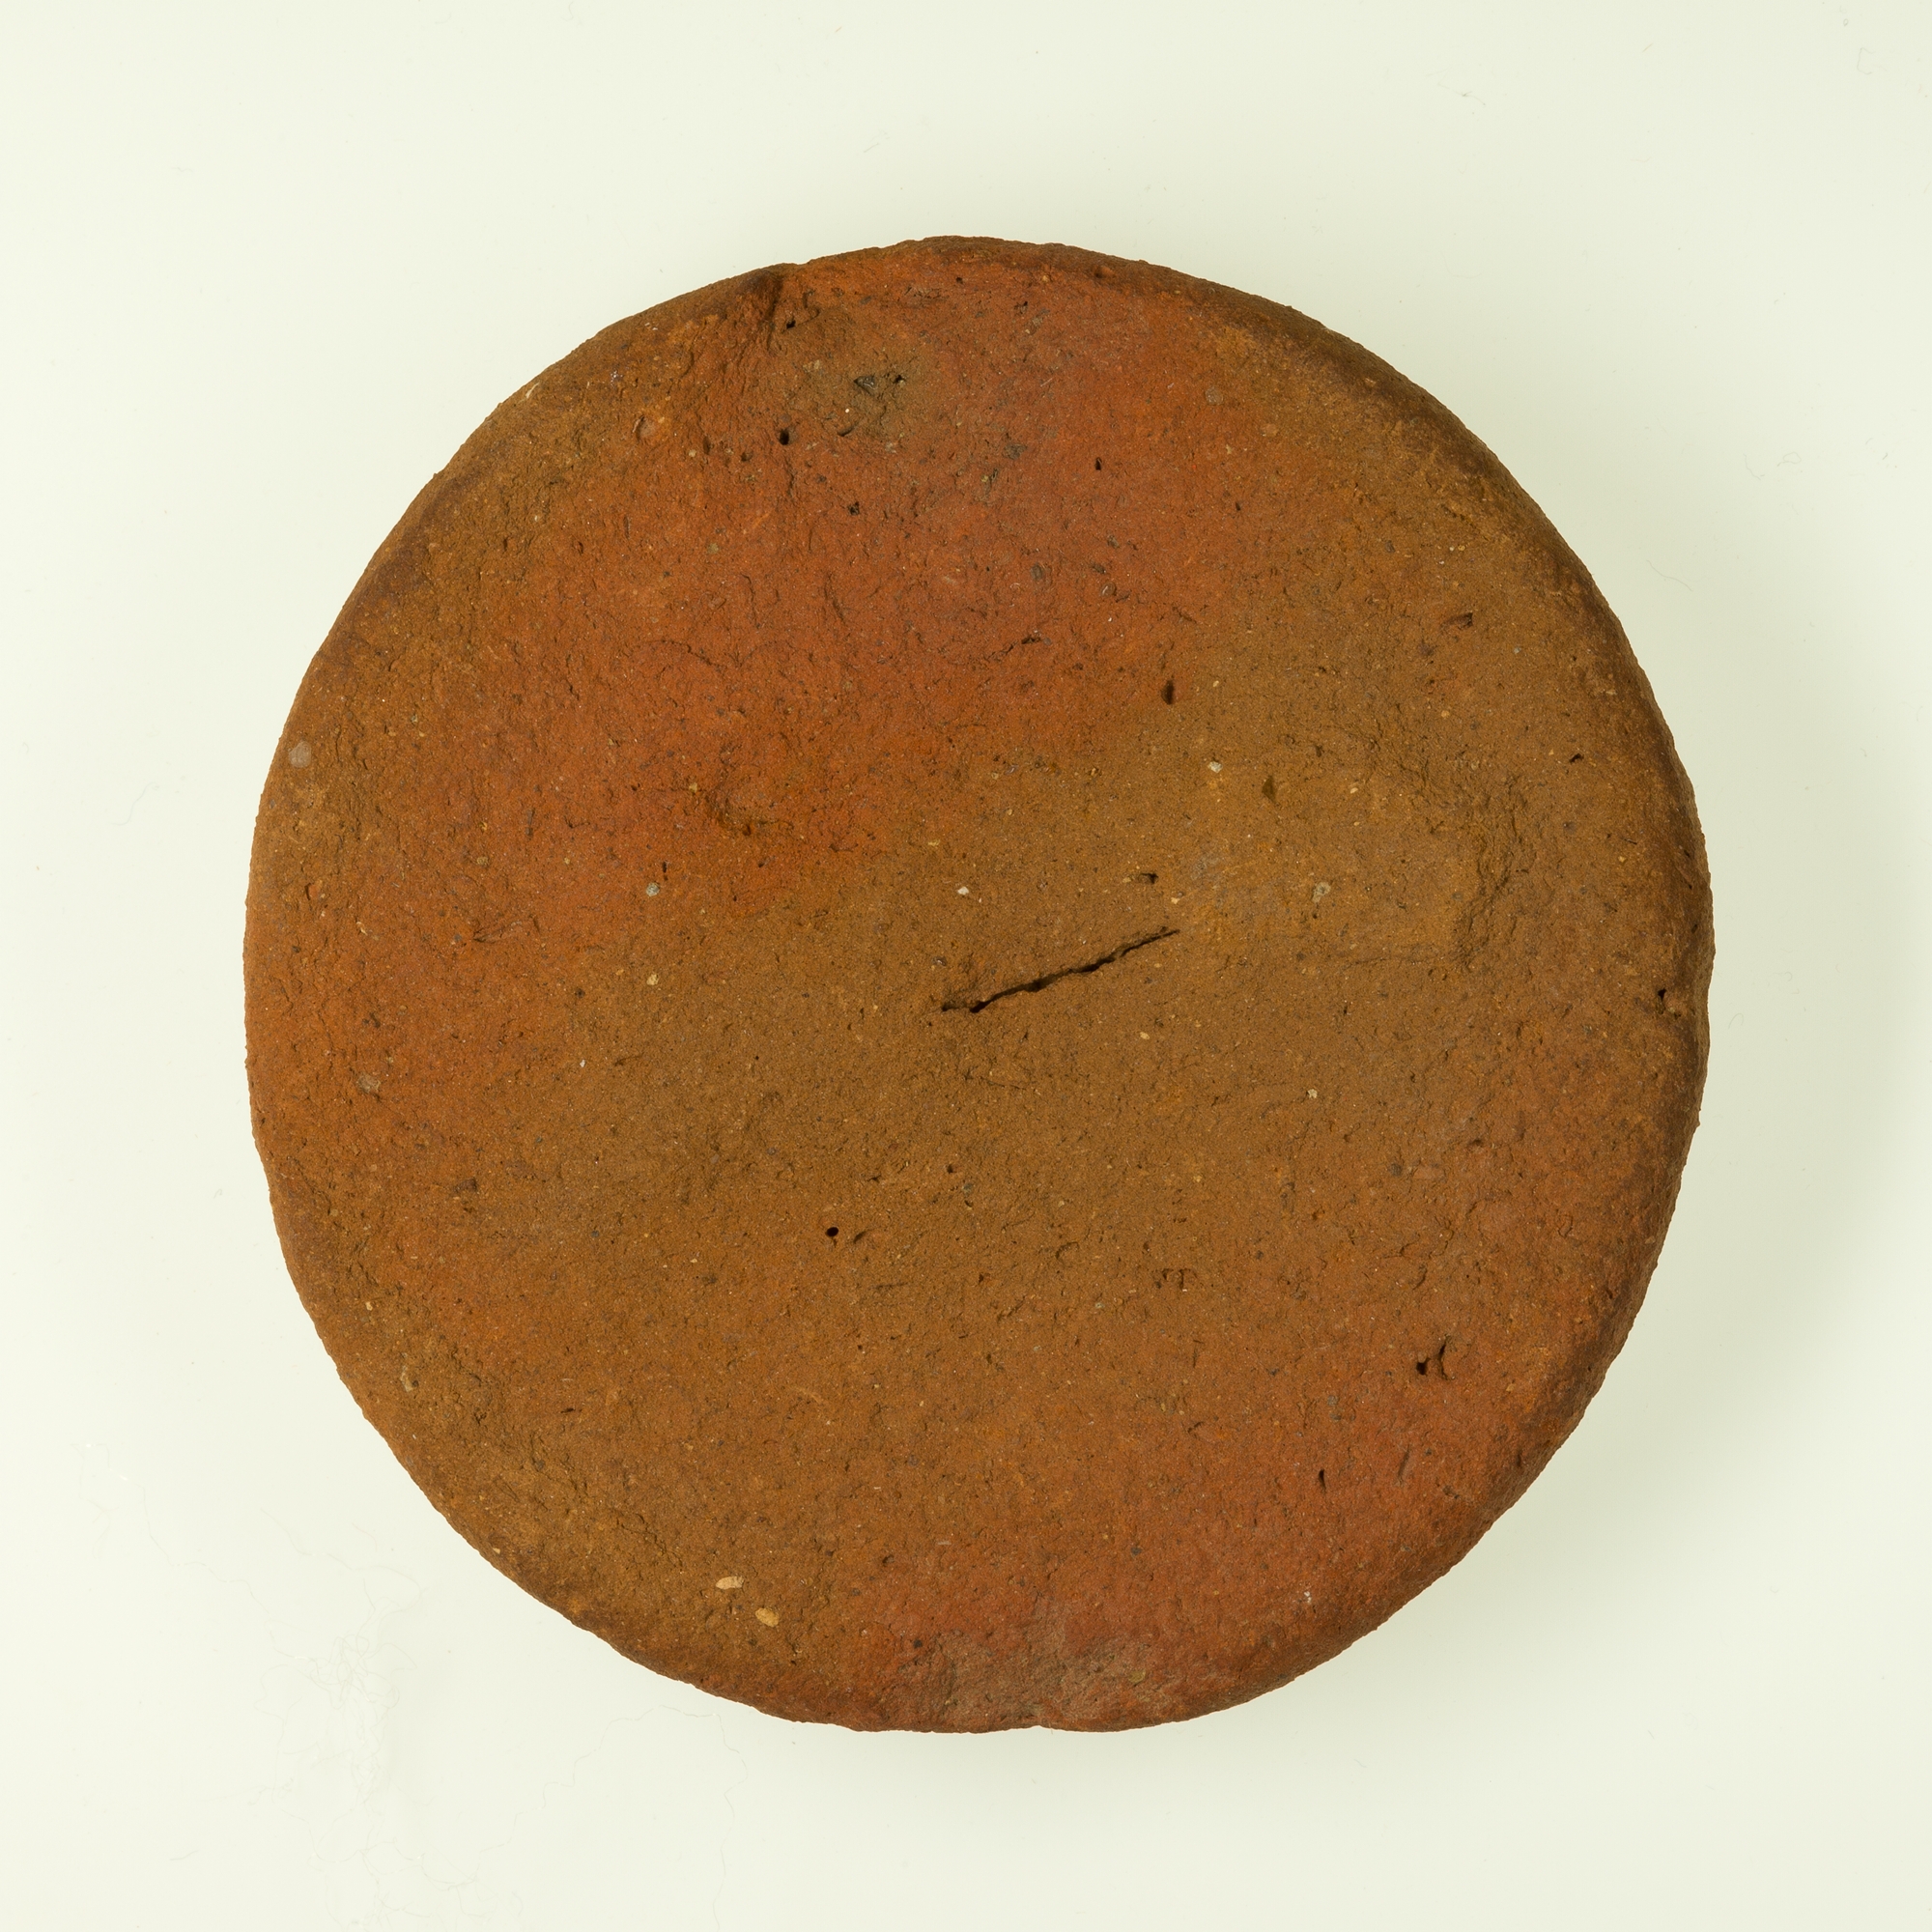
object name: weight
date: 1295-1070 BCE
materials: pottery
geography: egypt